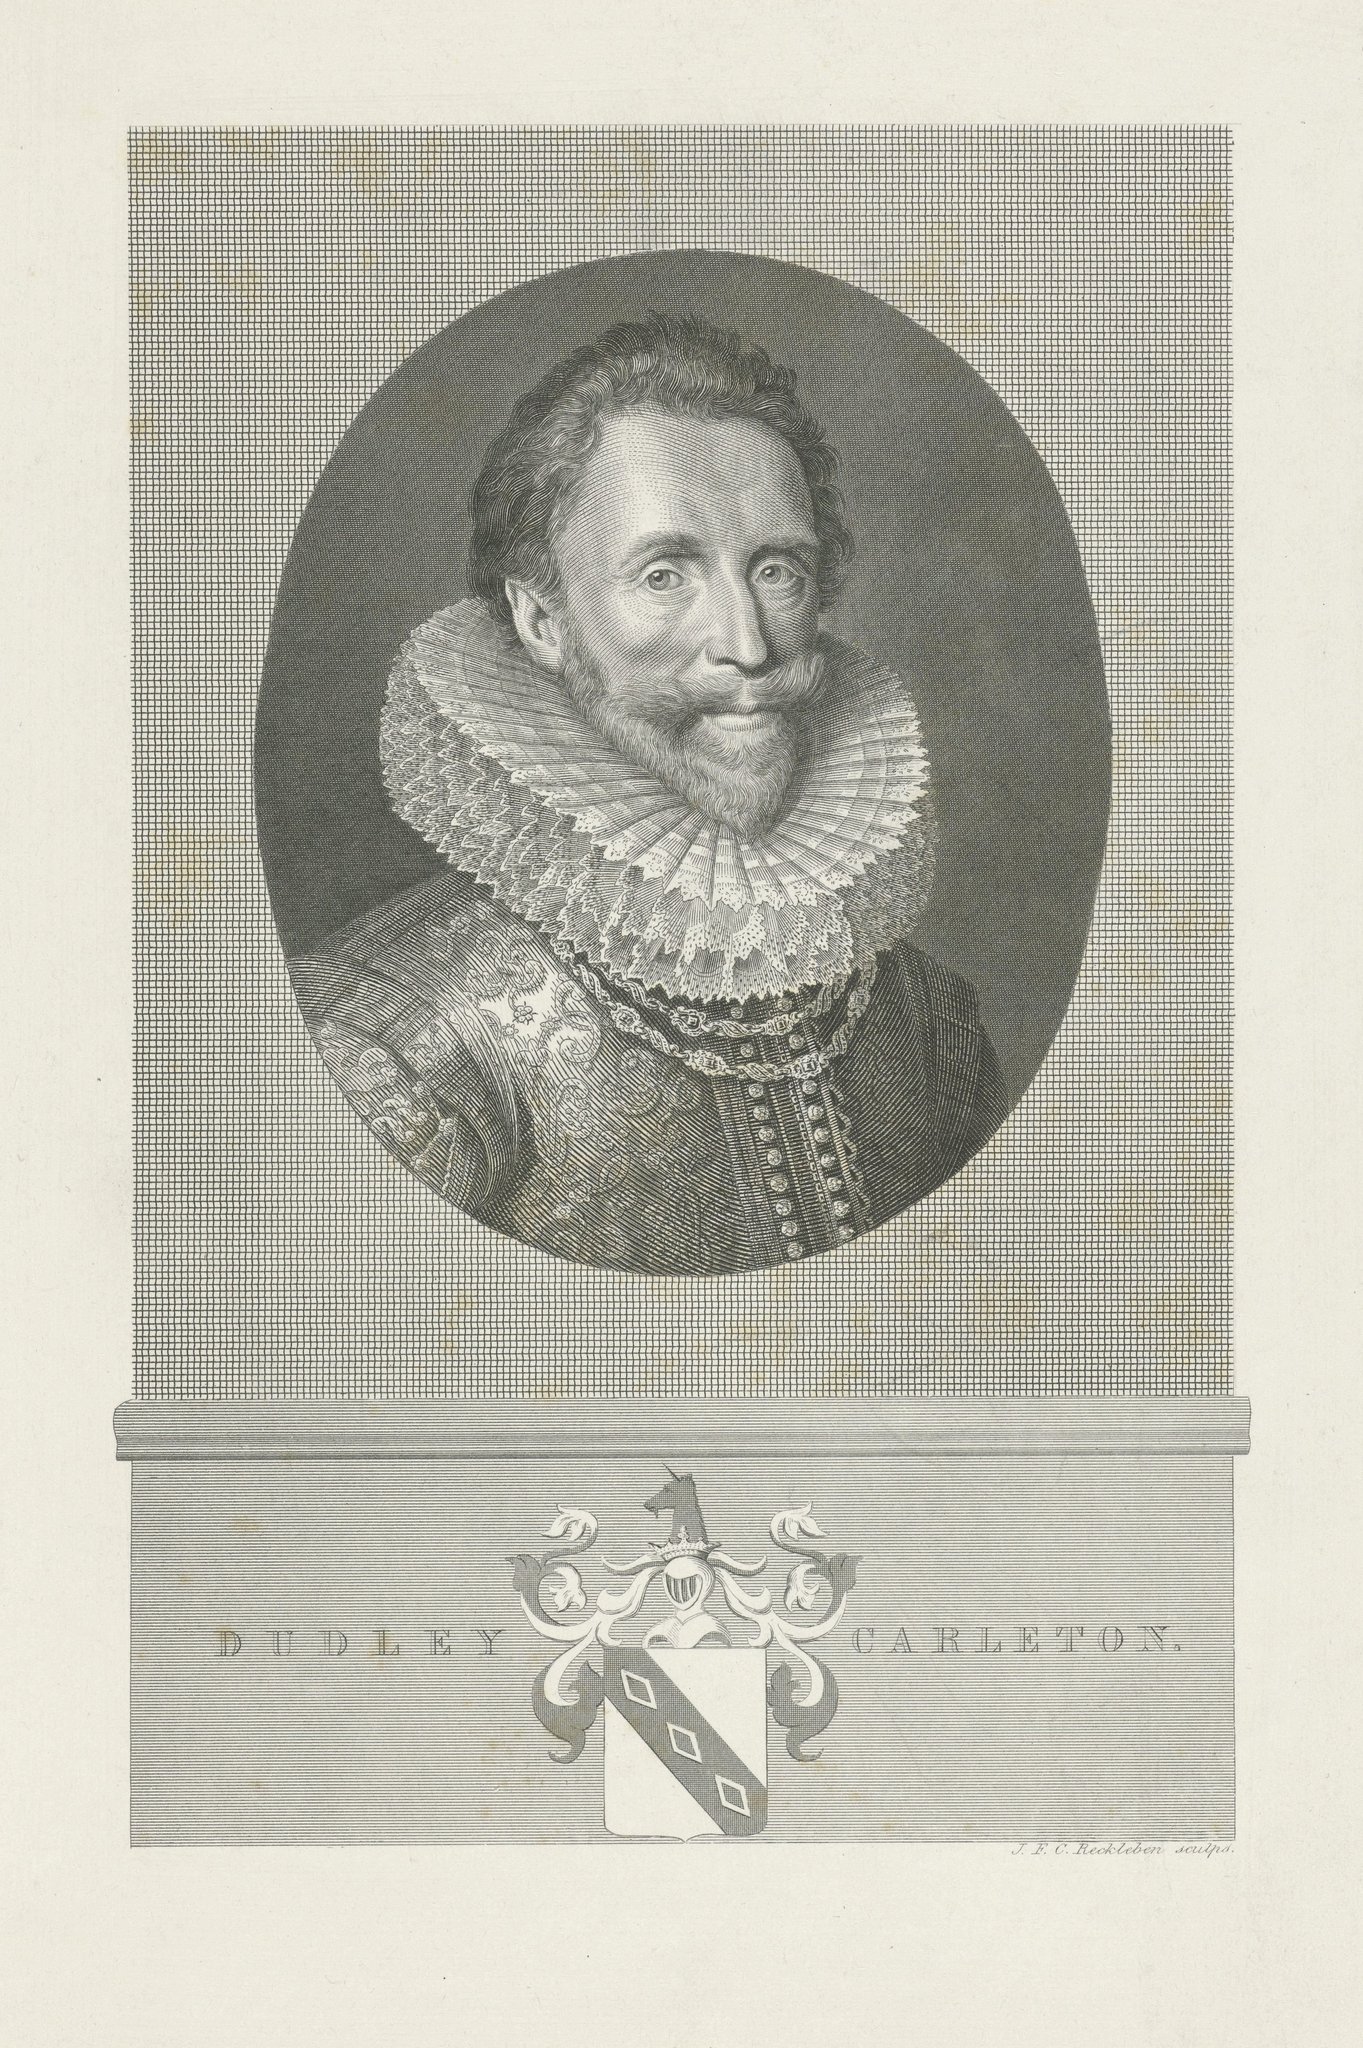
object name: print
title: Portret van Dudley Carlton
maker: jan frederik christiaan reckleben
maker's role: print maker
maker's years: 1819-1879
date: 1855-1857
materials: paper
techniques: engraving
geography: amsterdam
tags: dudley carlton (graaf van dorchester)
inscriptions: collector's mark: Lugt 2228, collector's mark: Lugt 2488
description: Illustratie in: Arend, Johannes Pieter. Algemeene geschiedenis des vaderlands van de vroegste tijden tot op heden. 5 delen, Amsterdam: Schleijer, J.F. 1840-1884, dl. 3.2, p. 602.